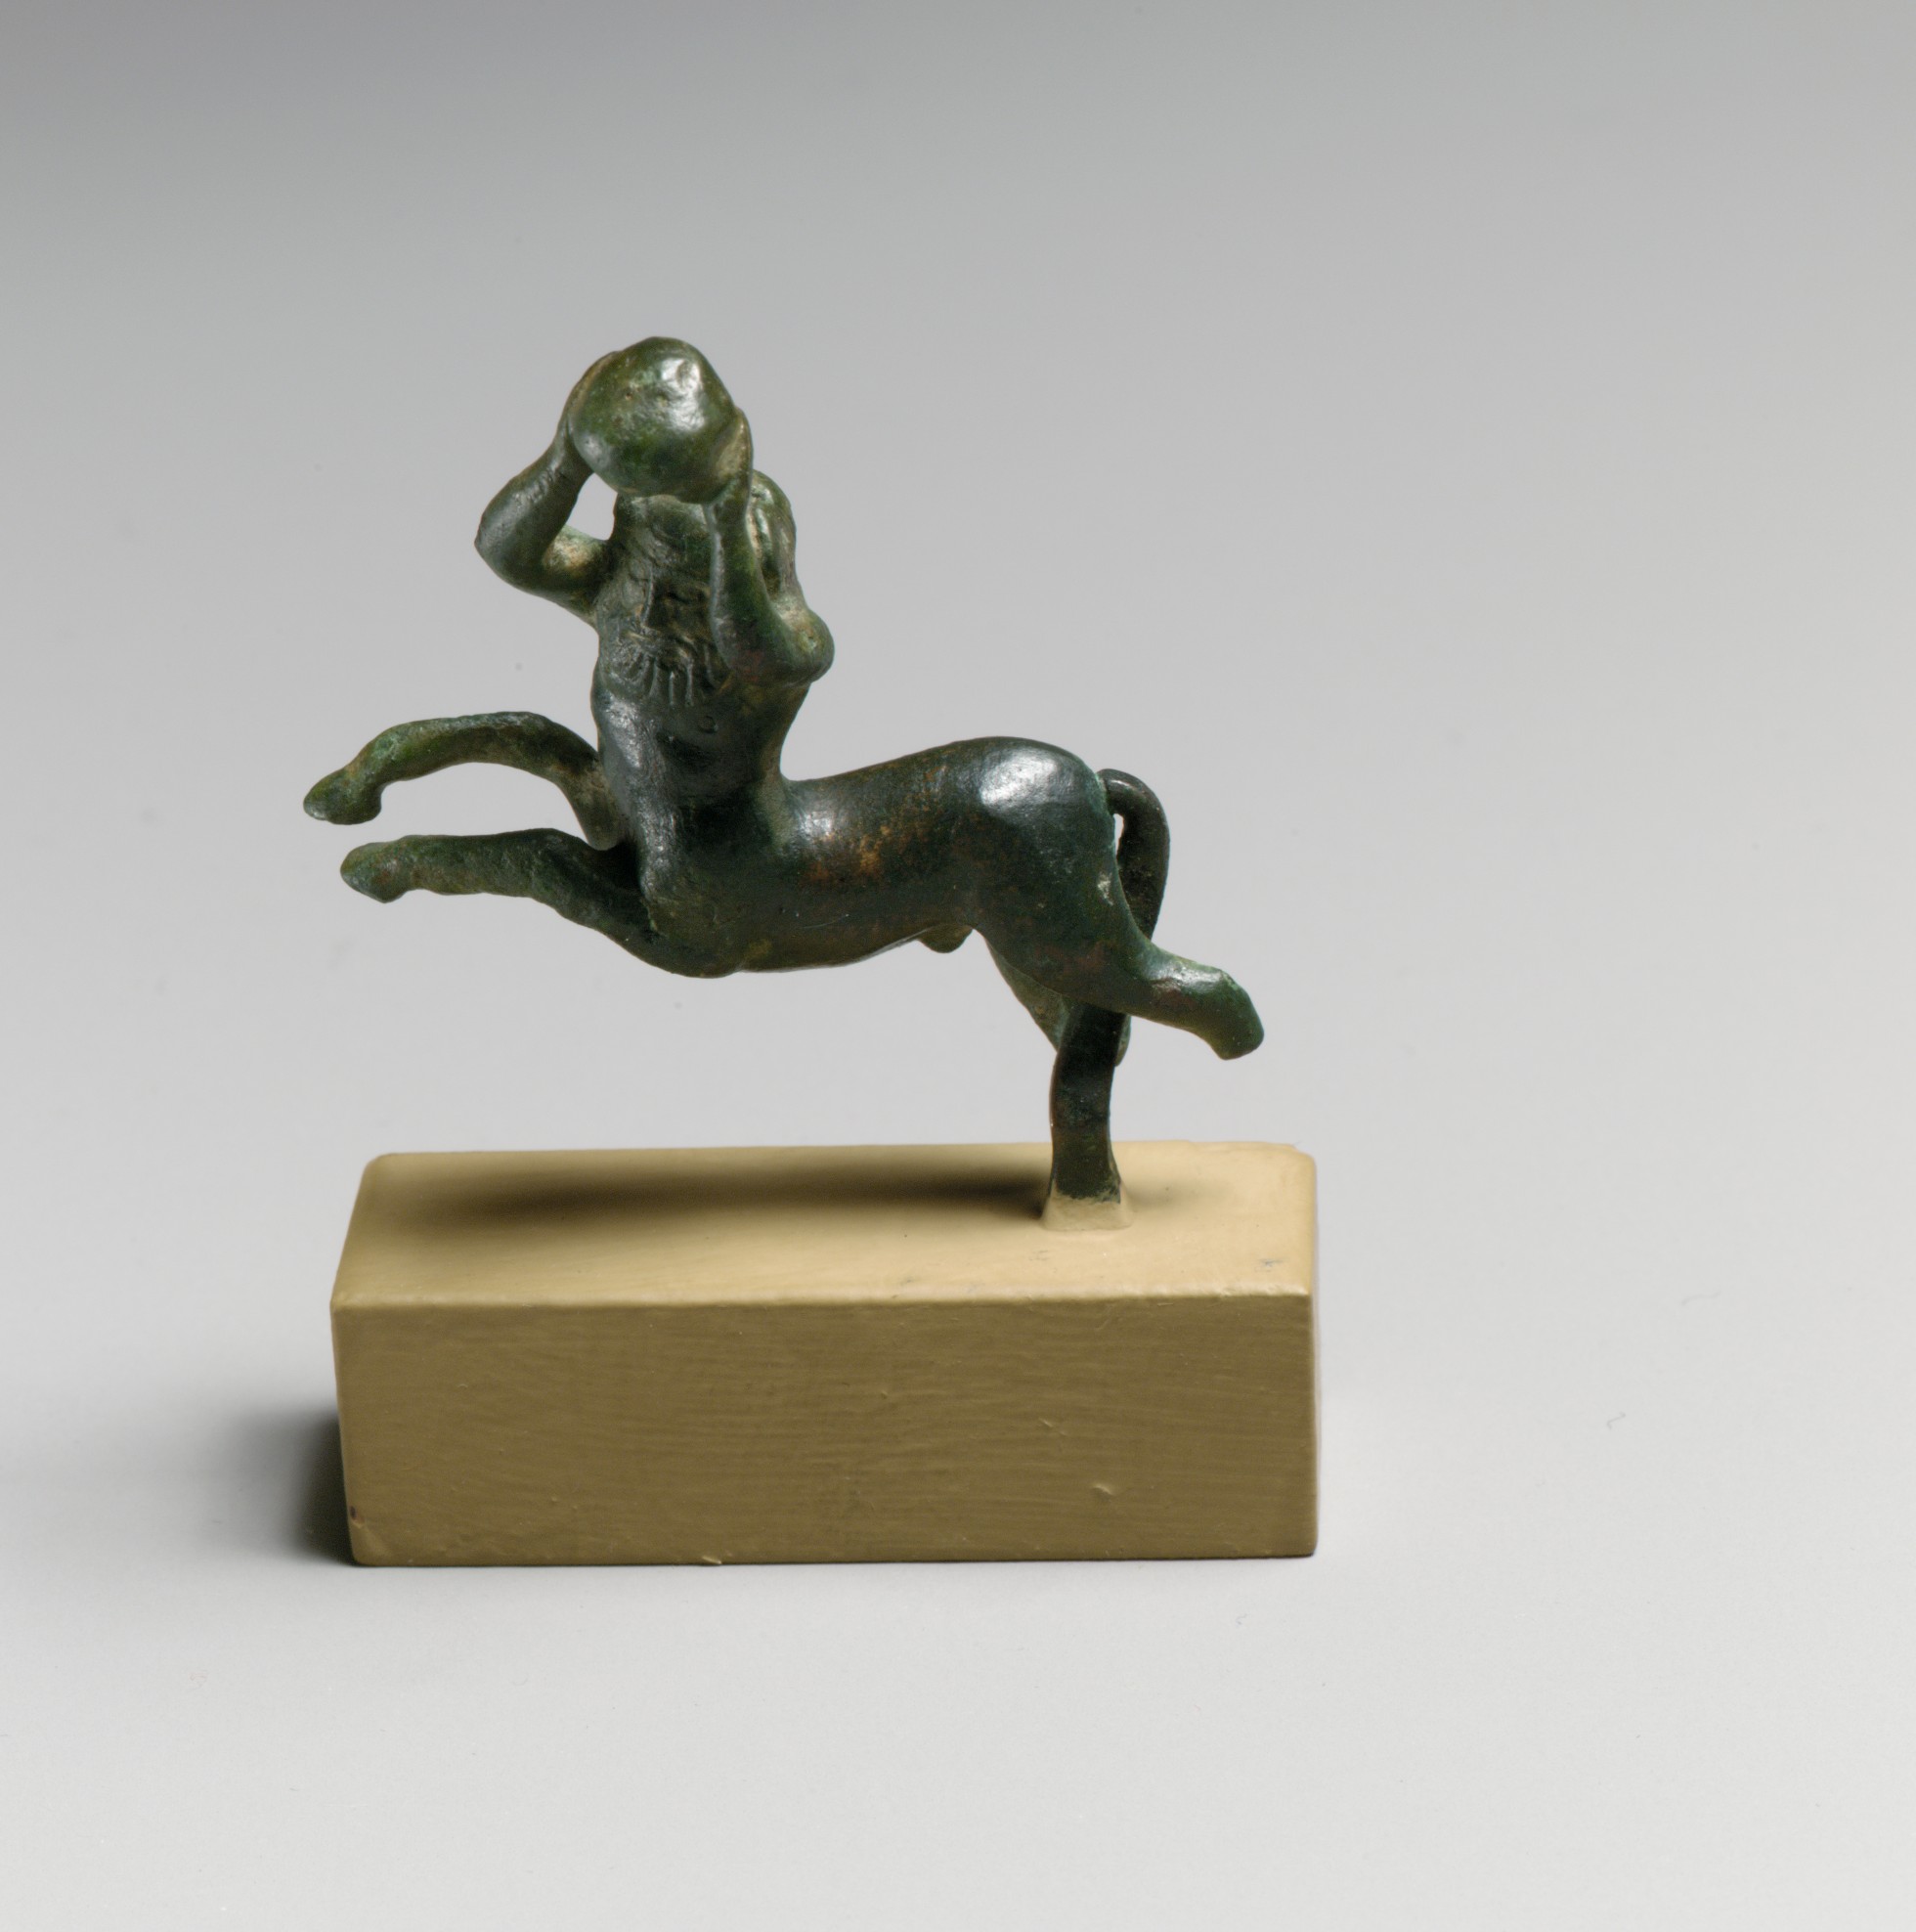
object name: statuette of a centaur hurling a stone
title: Bronze centaur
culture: greek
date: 434-401 BCE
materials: bronze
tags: centaurs